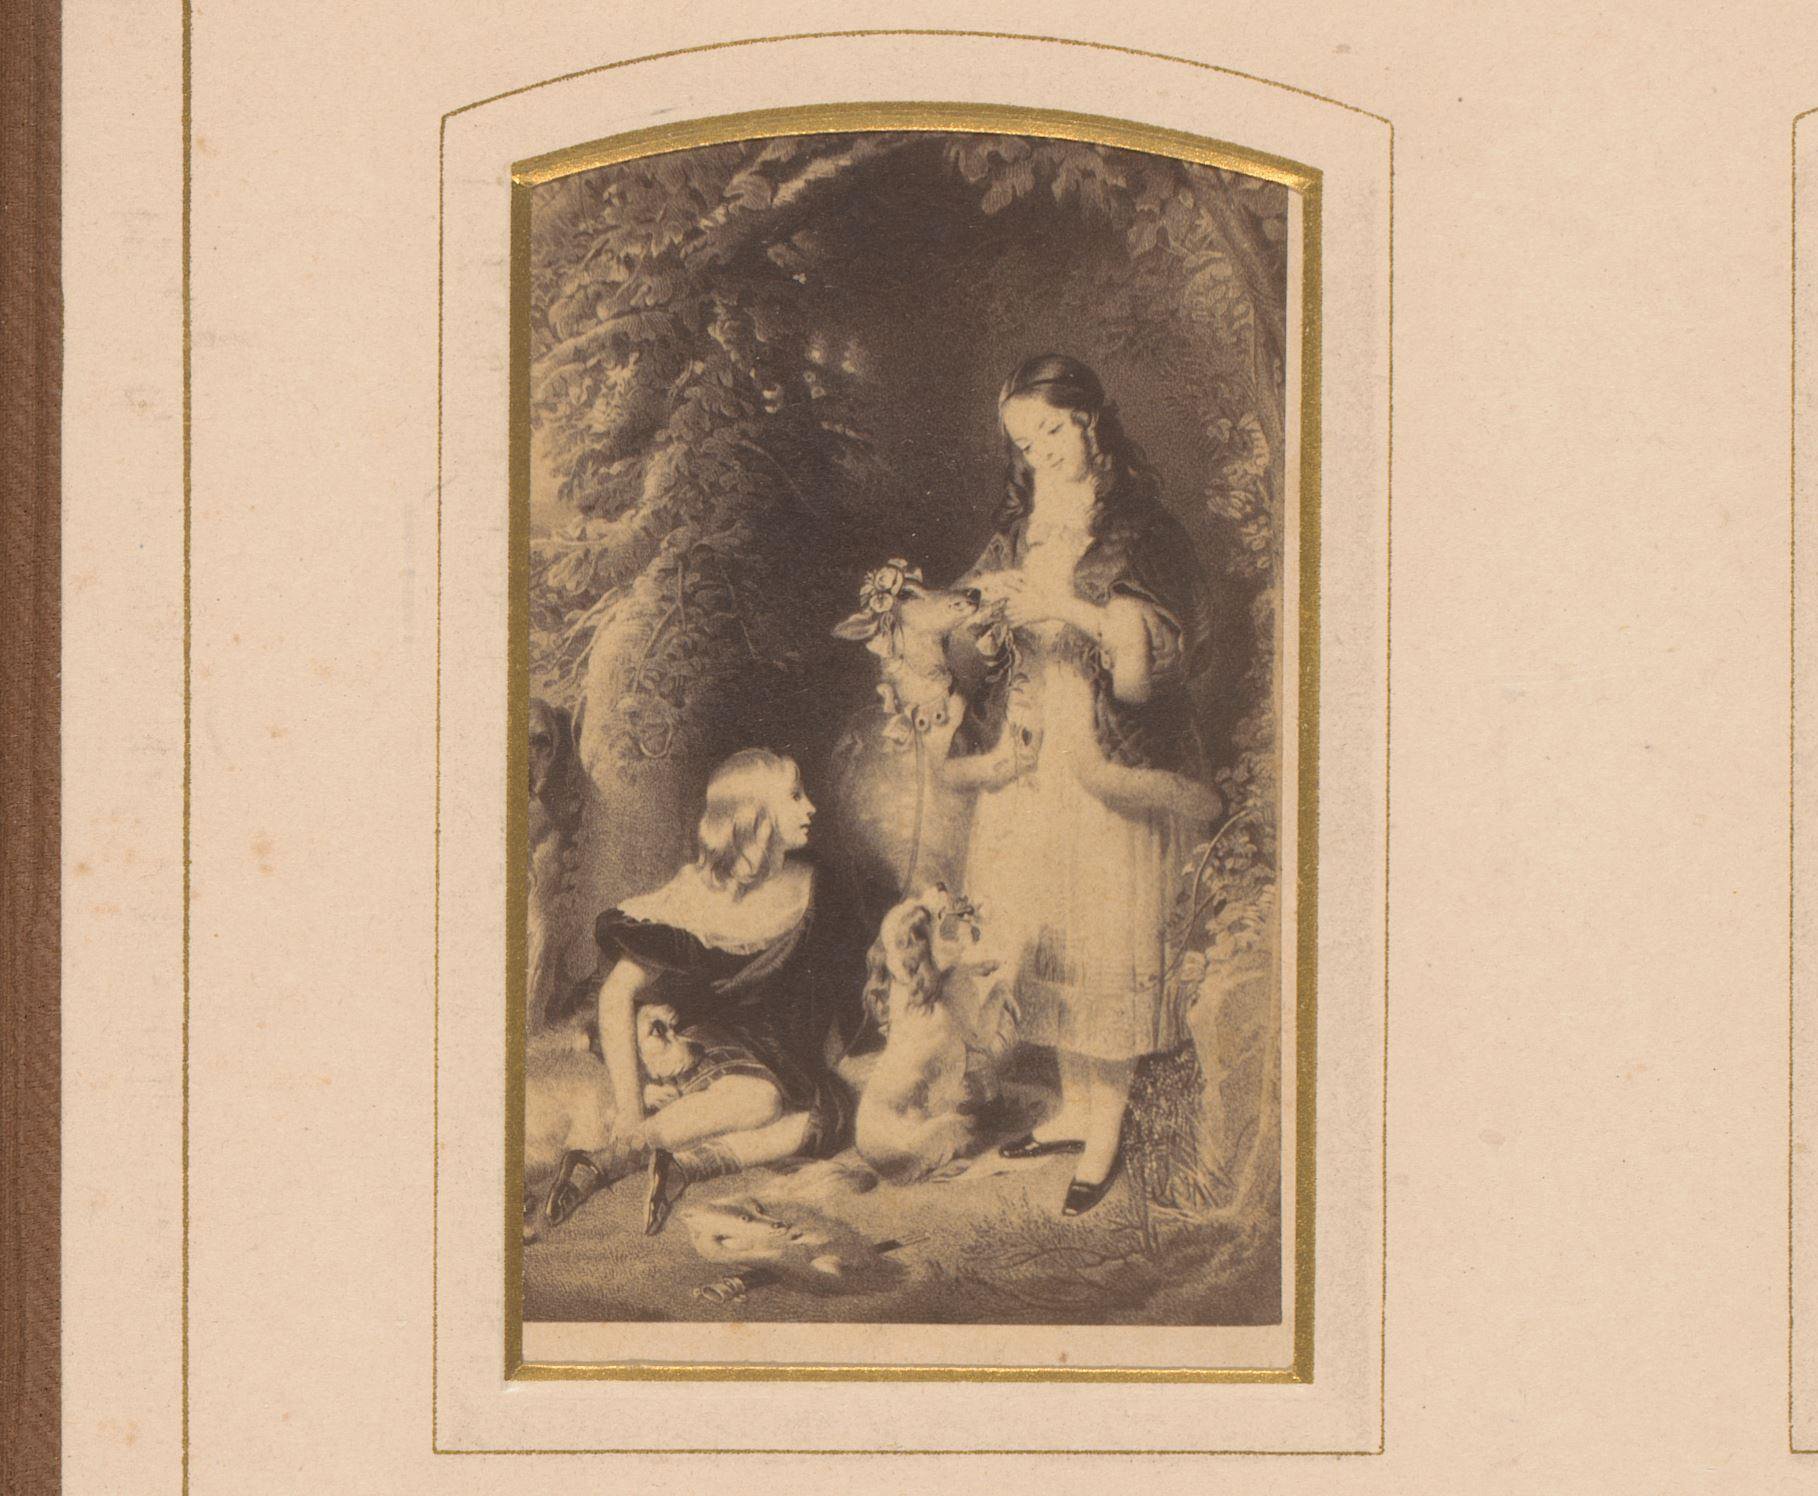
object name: carte de visite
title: Fotoreproductie van een schilderij met twee kinderen, een hert en honden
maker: alfred le jeune chardon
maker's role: printer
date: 1850-1900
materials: cardboard, photographic support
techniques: albumen print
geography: paris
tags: hoofed animals: deer, child (+ two persons), dog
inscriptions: name: ‘Amis d'enfance’, inscription: ‘PHOTOGRAPHIE A. CHARDON Jeune/ Paris, 3 Rue Racine./ BULLA FRÈRES EDITEURS./ 16, RUE Tiquetonne/ PARIS.’